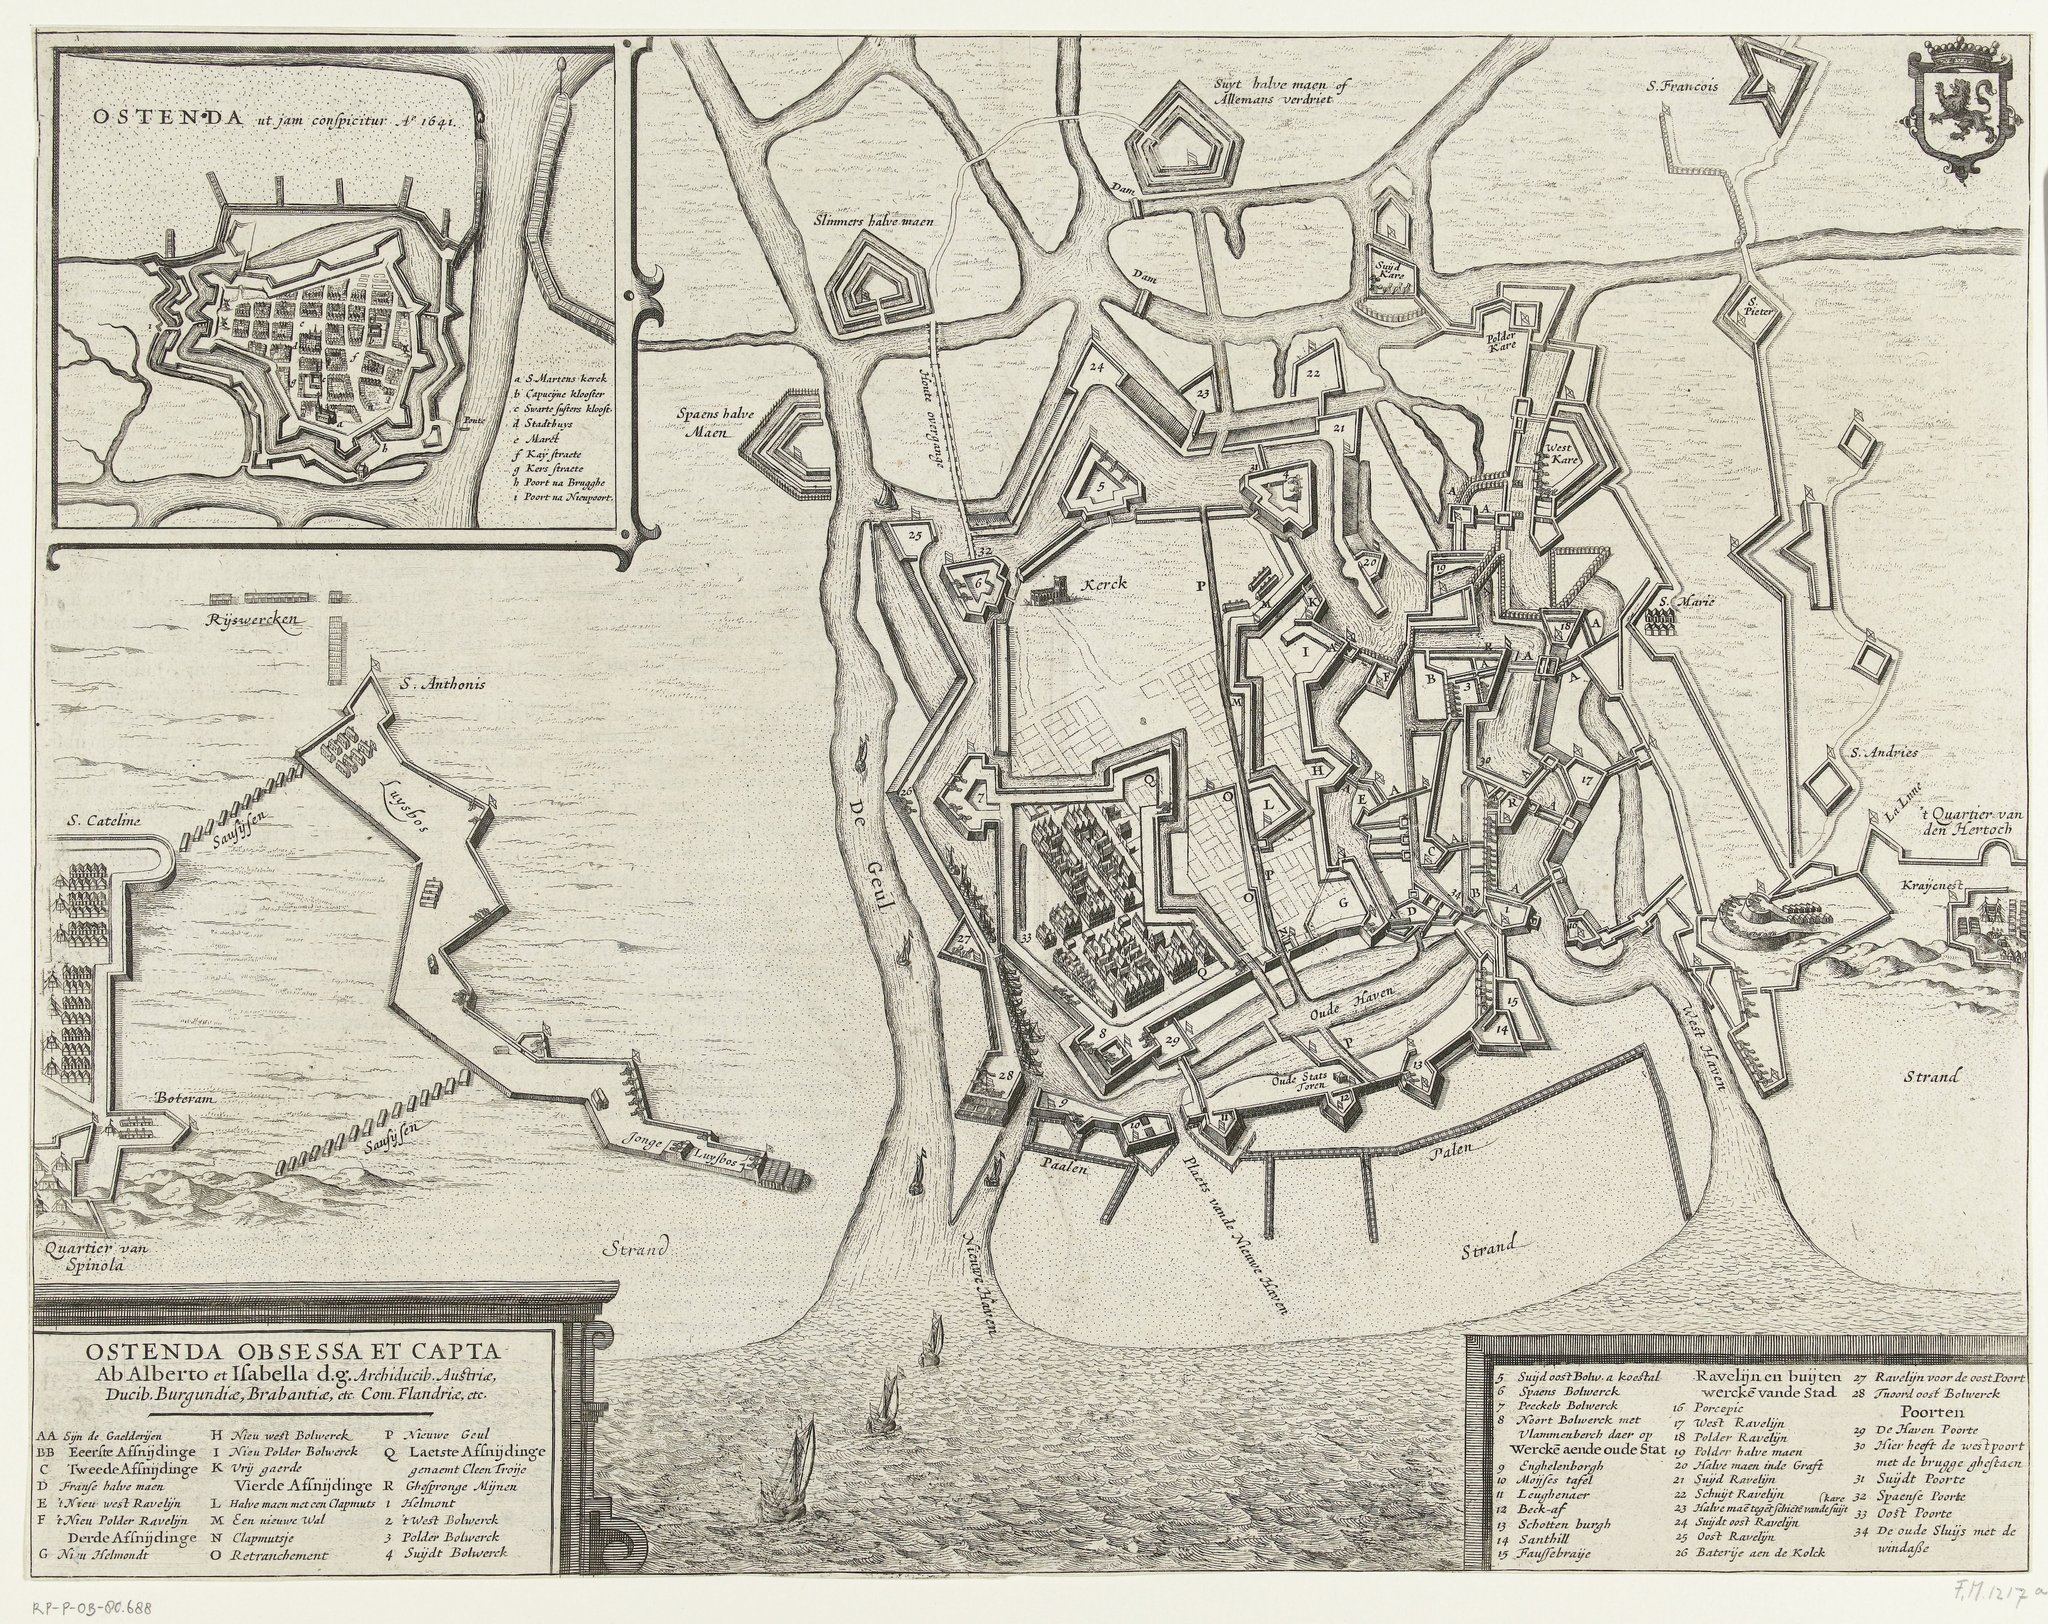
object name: history print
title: Ostenda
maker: Anonymous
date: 1647-1649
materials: paper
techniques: etching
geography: northern netherlands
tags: siege, position war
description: Beleg van Oostende. Kaart van de verdedigings- en aanvalslinies rondom de stad en in het omliggende gebied, links het kwartier van Spinola, rechts het kwartier van aartshertog Albrecht. Onderaan twee cartouches met de titel en de legenda's A-R en 1-34. Linksboven een inzet met een plattegrond van de stad in 1641. Op een dubbelblad genomen uit het Stedenboek van Blaeu, bedrukt op achterzijde met tekst in het Latijn.